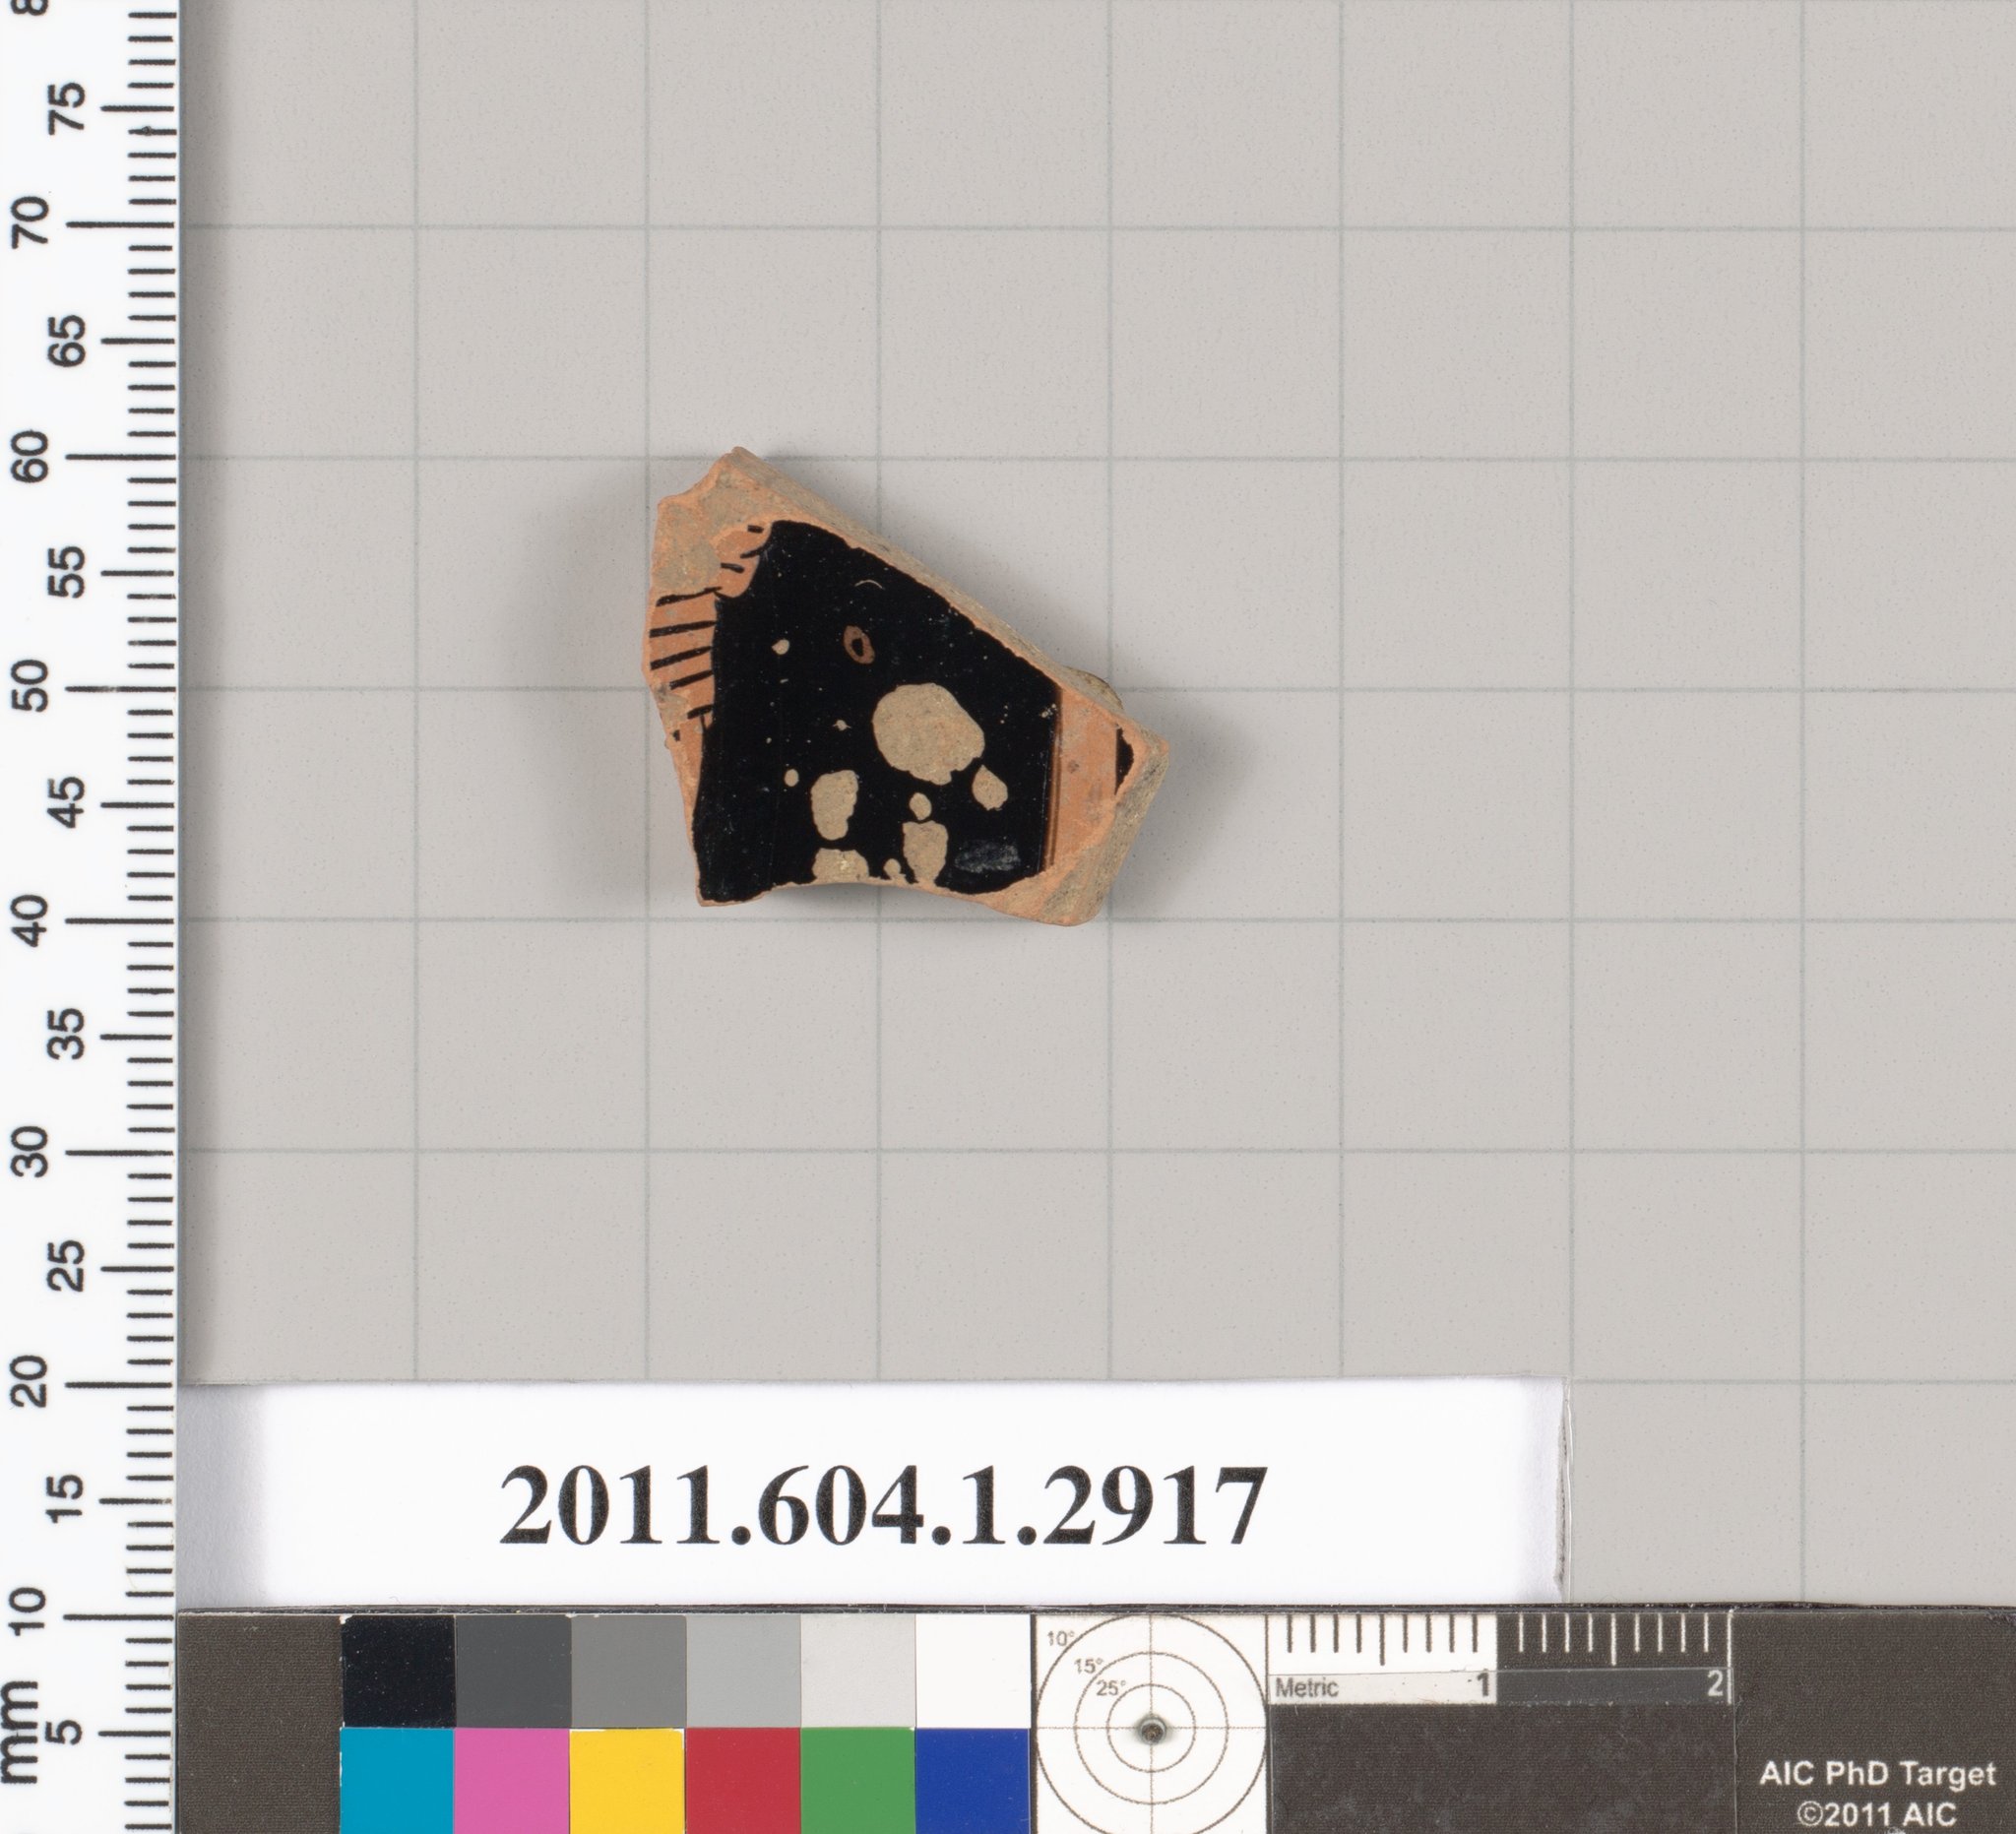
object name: kylix fragment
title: Terracotta fragment of a kylix (drinking cup)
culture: greek, attic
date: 500-476 BCE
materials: terracotta